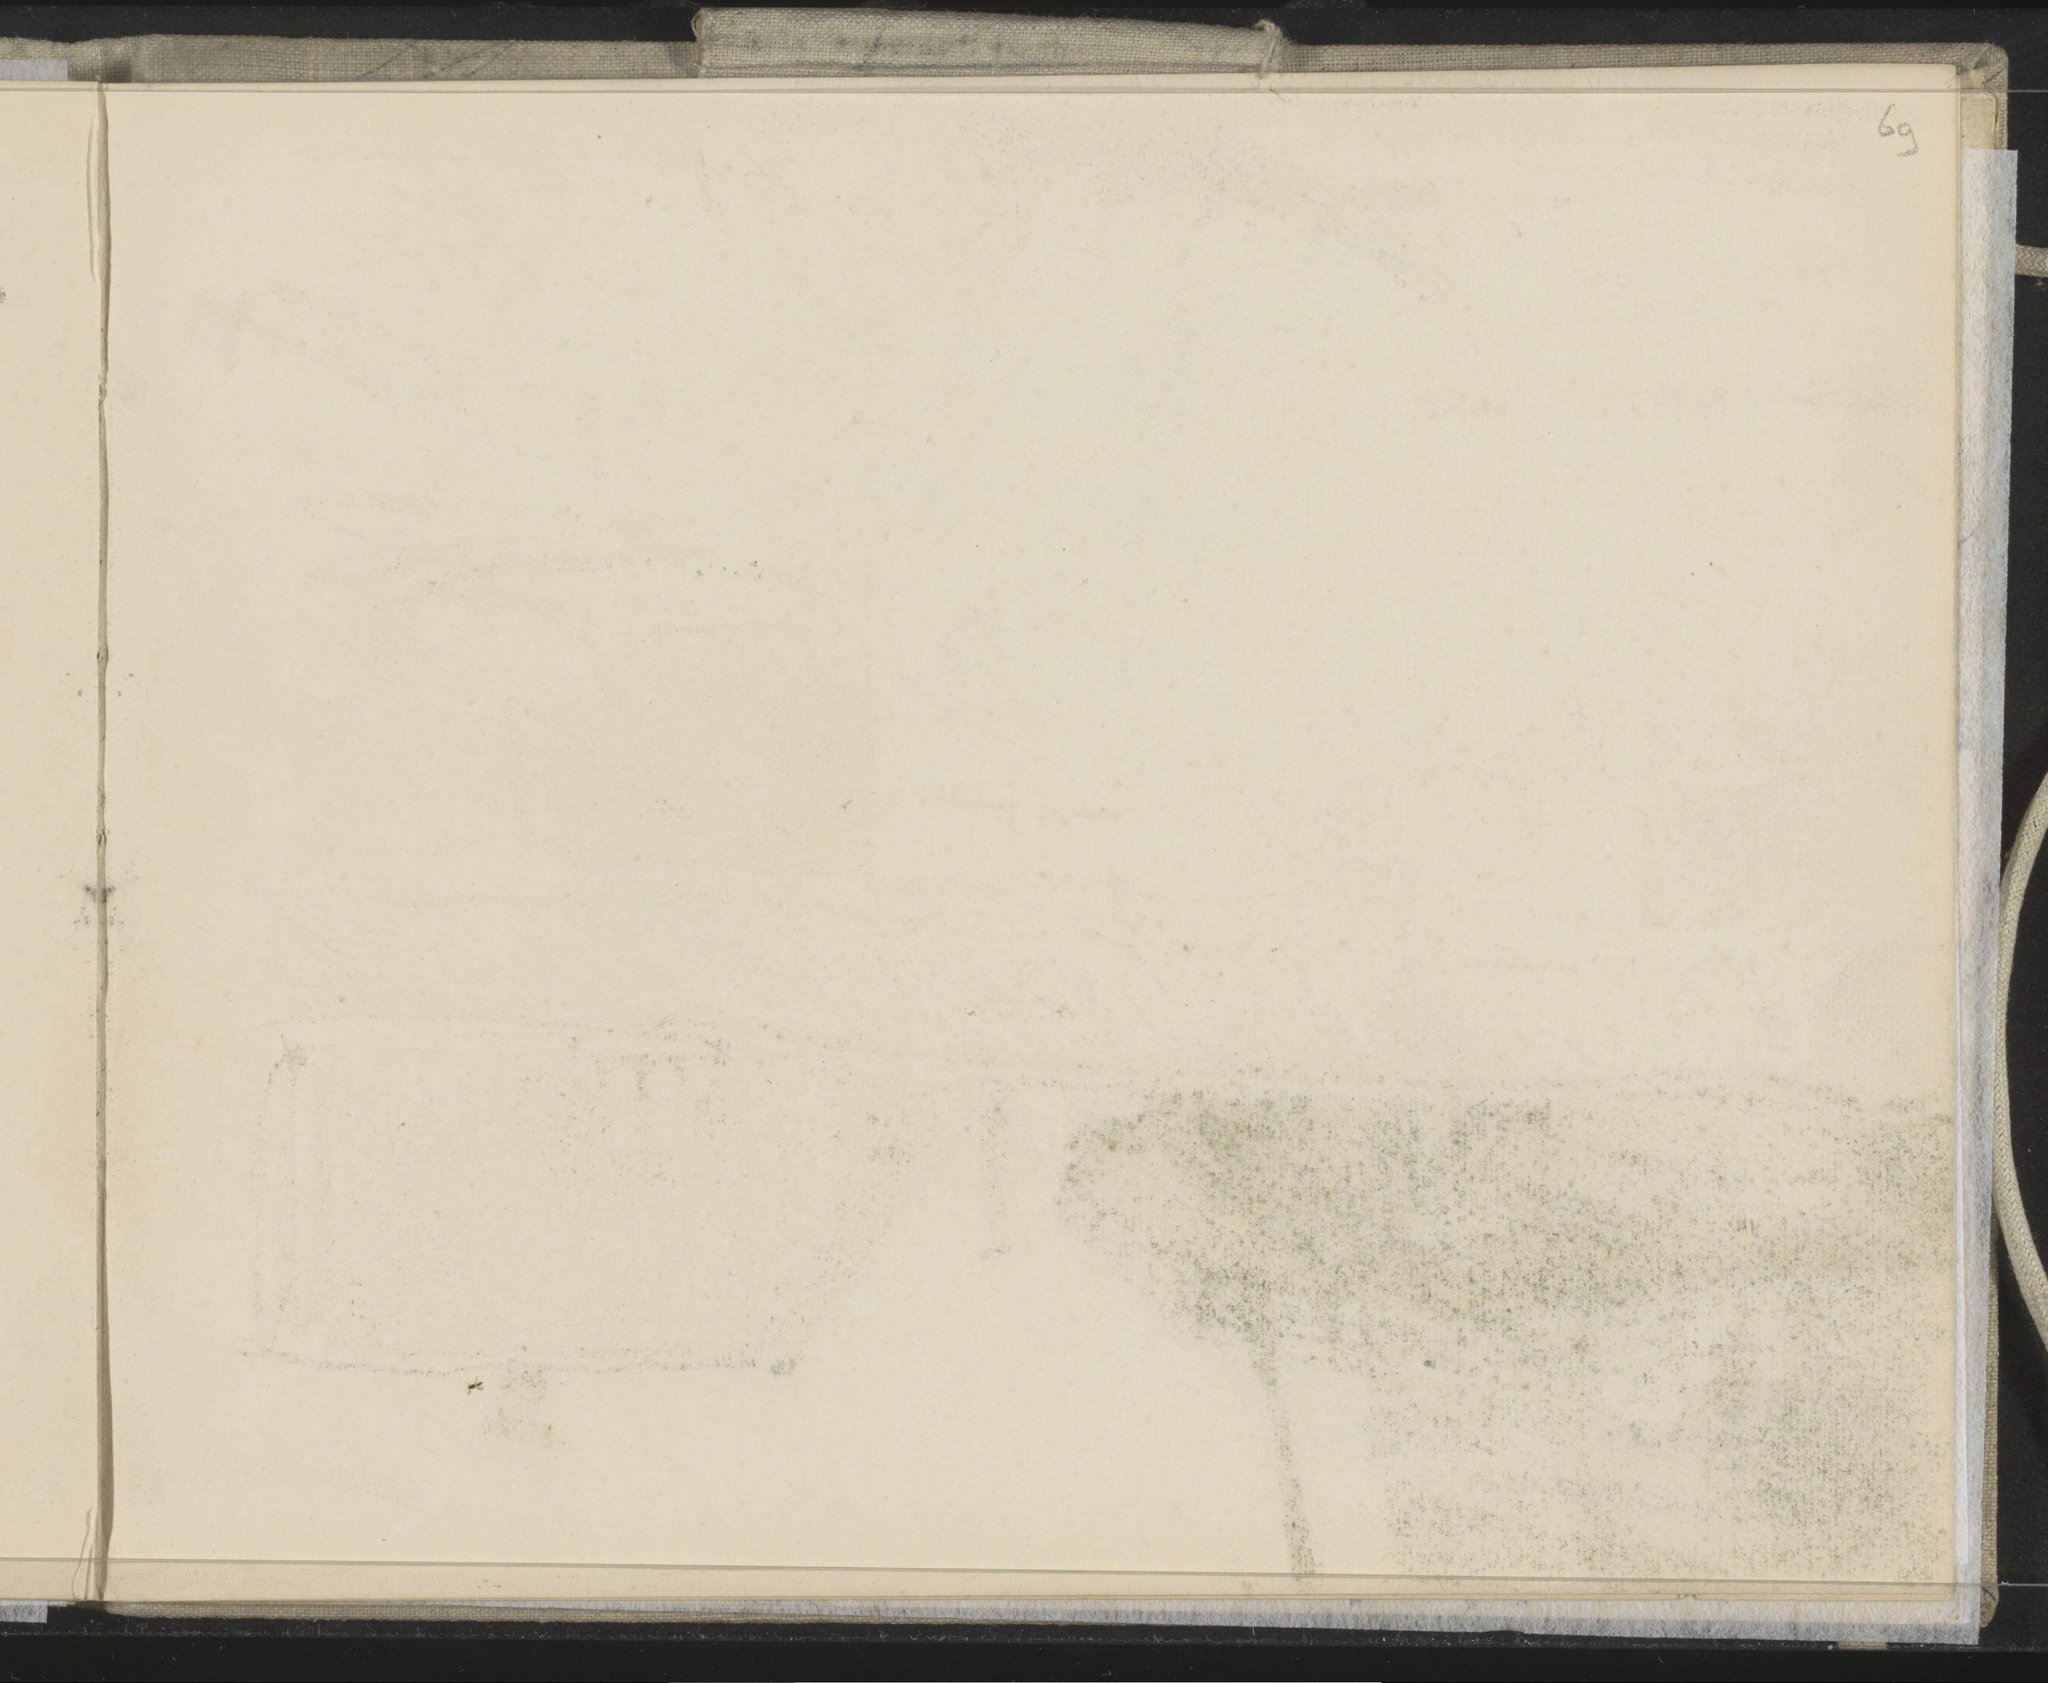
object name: sketchbook leaf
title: Abklatsch van de krijttekening op pagina 68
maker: willem witsen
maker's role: draughtsman, painter, print maker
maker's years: 1860-1923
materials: paper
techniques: printmaking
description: Pagina 69 uit een schetsboek met 43 bladen.